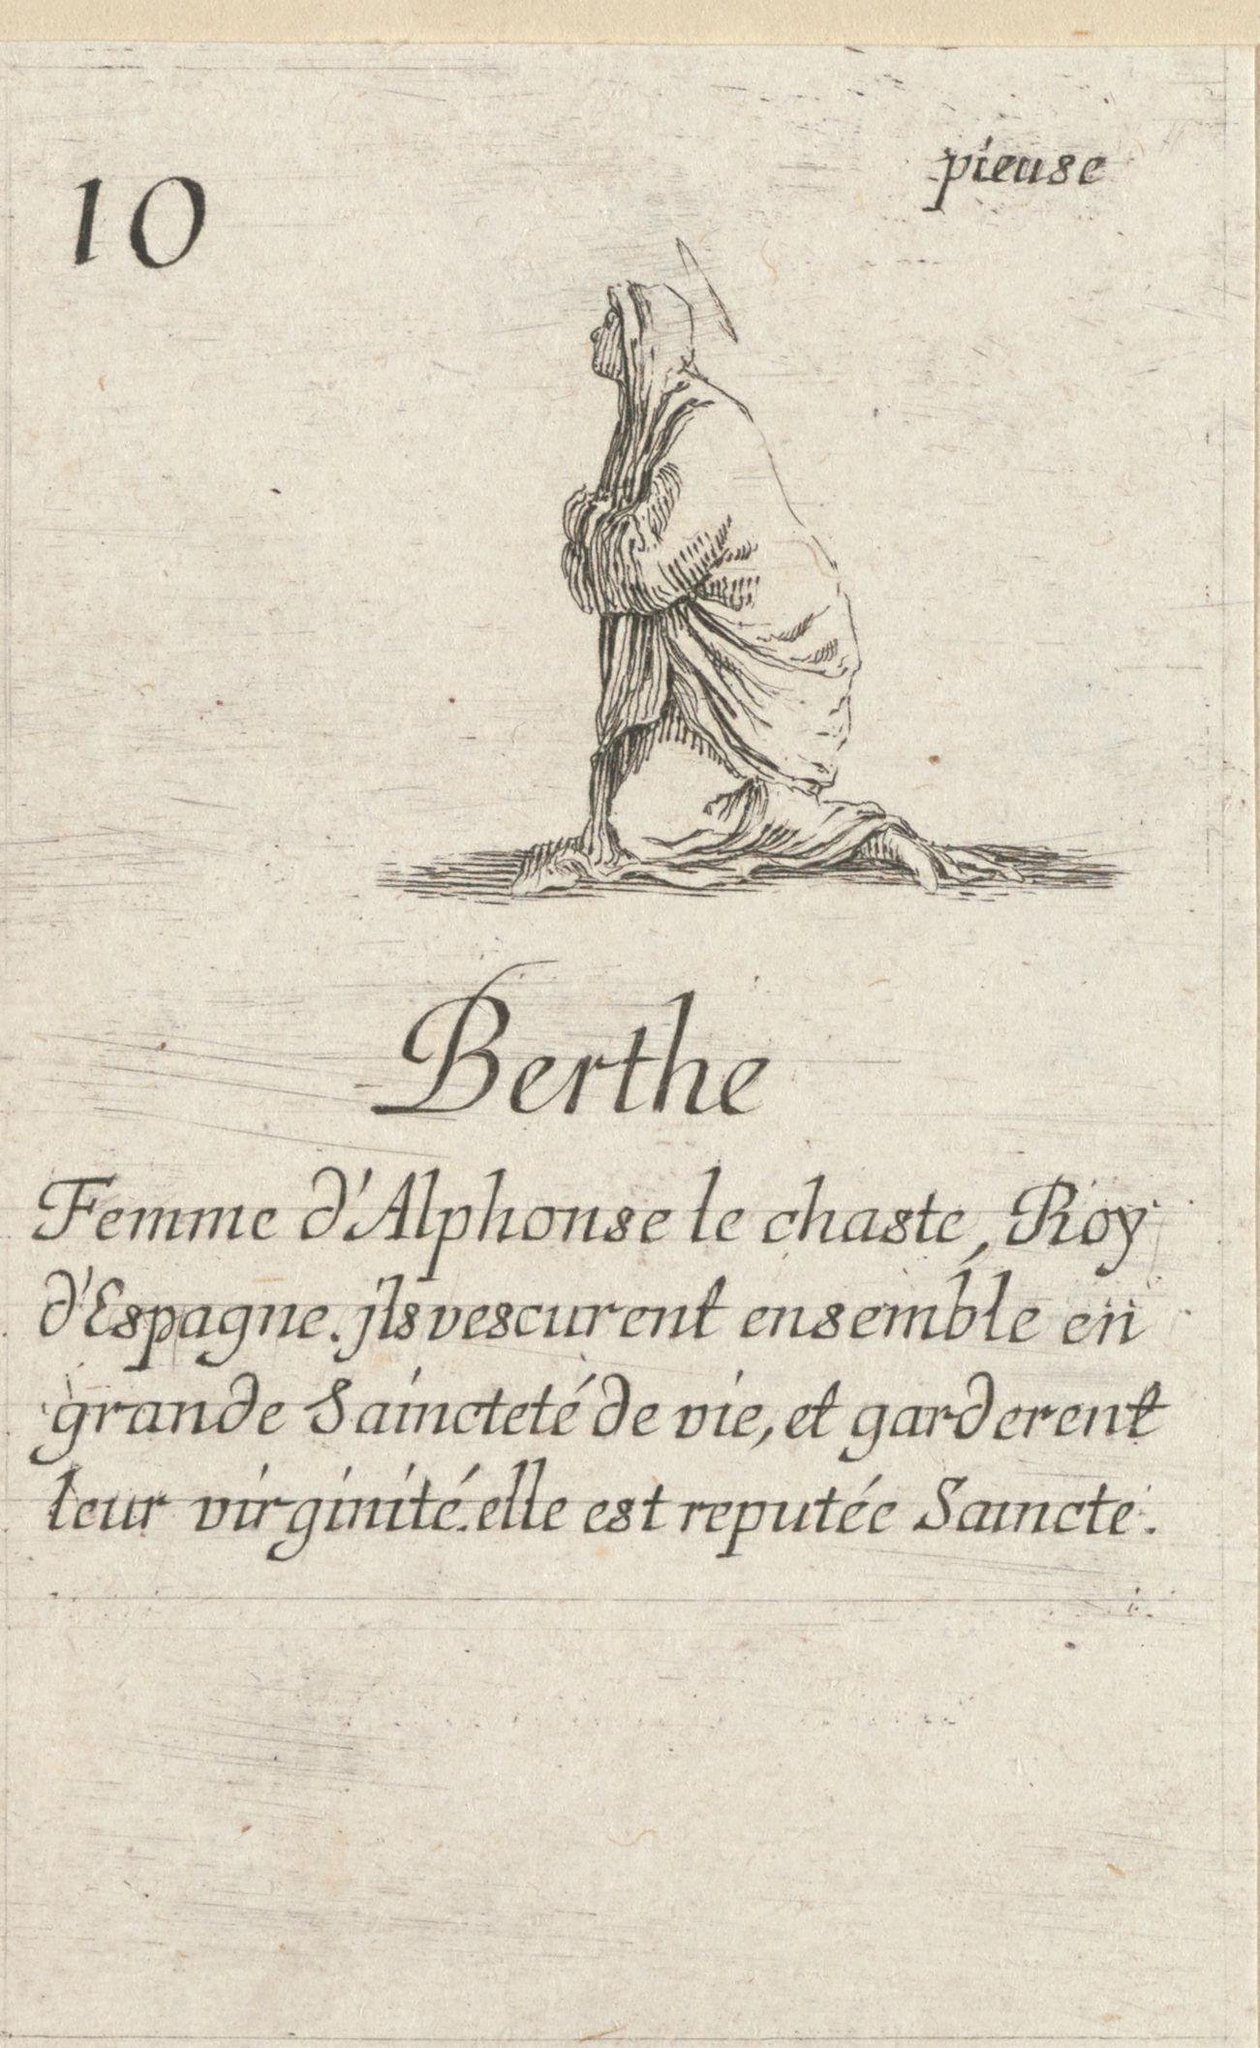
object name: print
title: Kaartspel met gerenommeerde heerseressen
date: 1620-1664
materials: paper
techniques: etching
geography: paris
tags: ruler, sovereign - bb - female ruler, kneeling figure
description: Deze prent maakt deel uit van een kaartspel met 52 kaarten met voorstellingen van beroemde koninginnen. De serie is uitgedacht door Jean Desmarests de Saint-Sorlin in opdracht van Kardinaal Mazarin. Het kaartspel werd gemaakt voor de jonge Lodewijk XIV, samen met het Jeu des Fables, Jeu de la Géographie en Jeu des Rois de France.